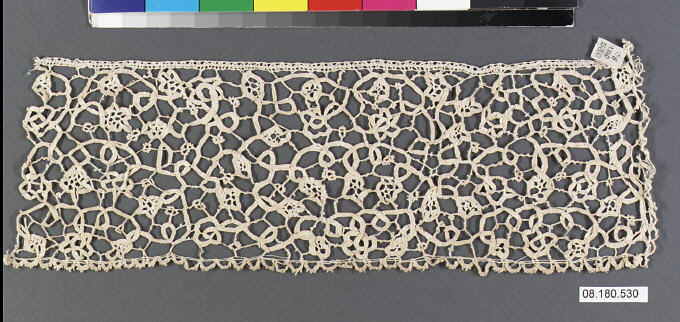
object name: fragment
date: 1701-1800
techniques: lace